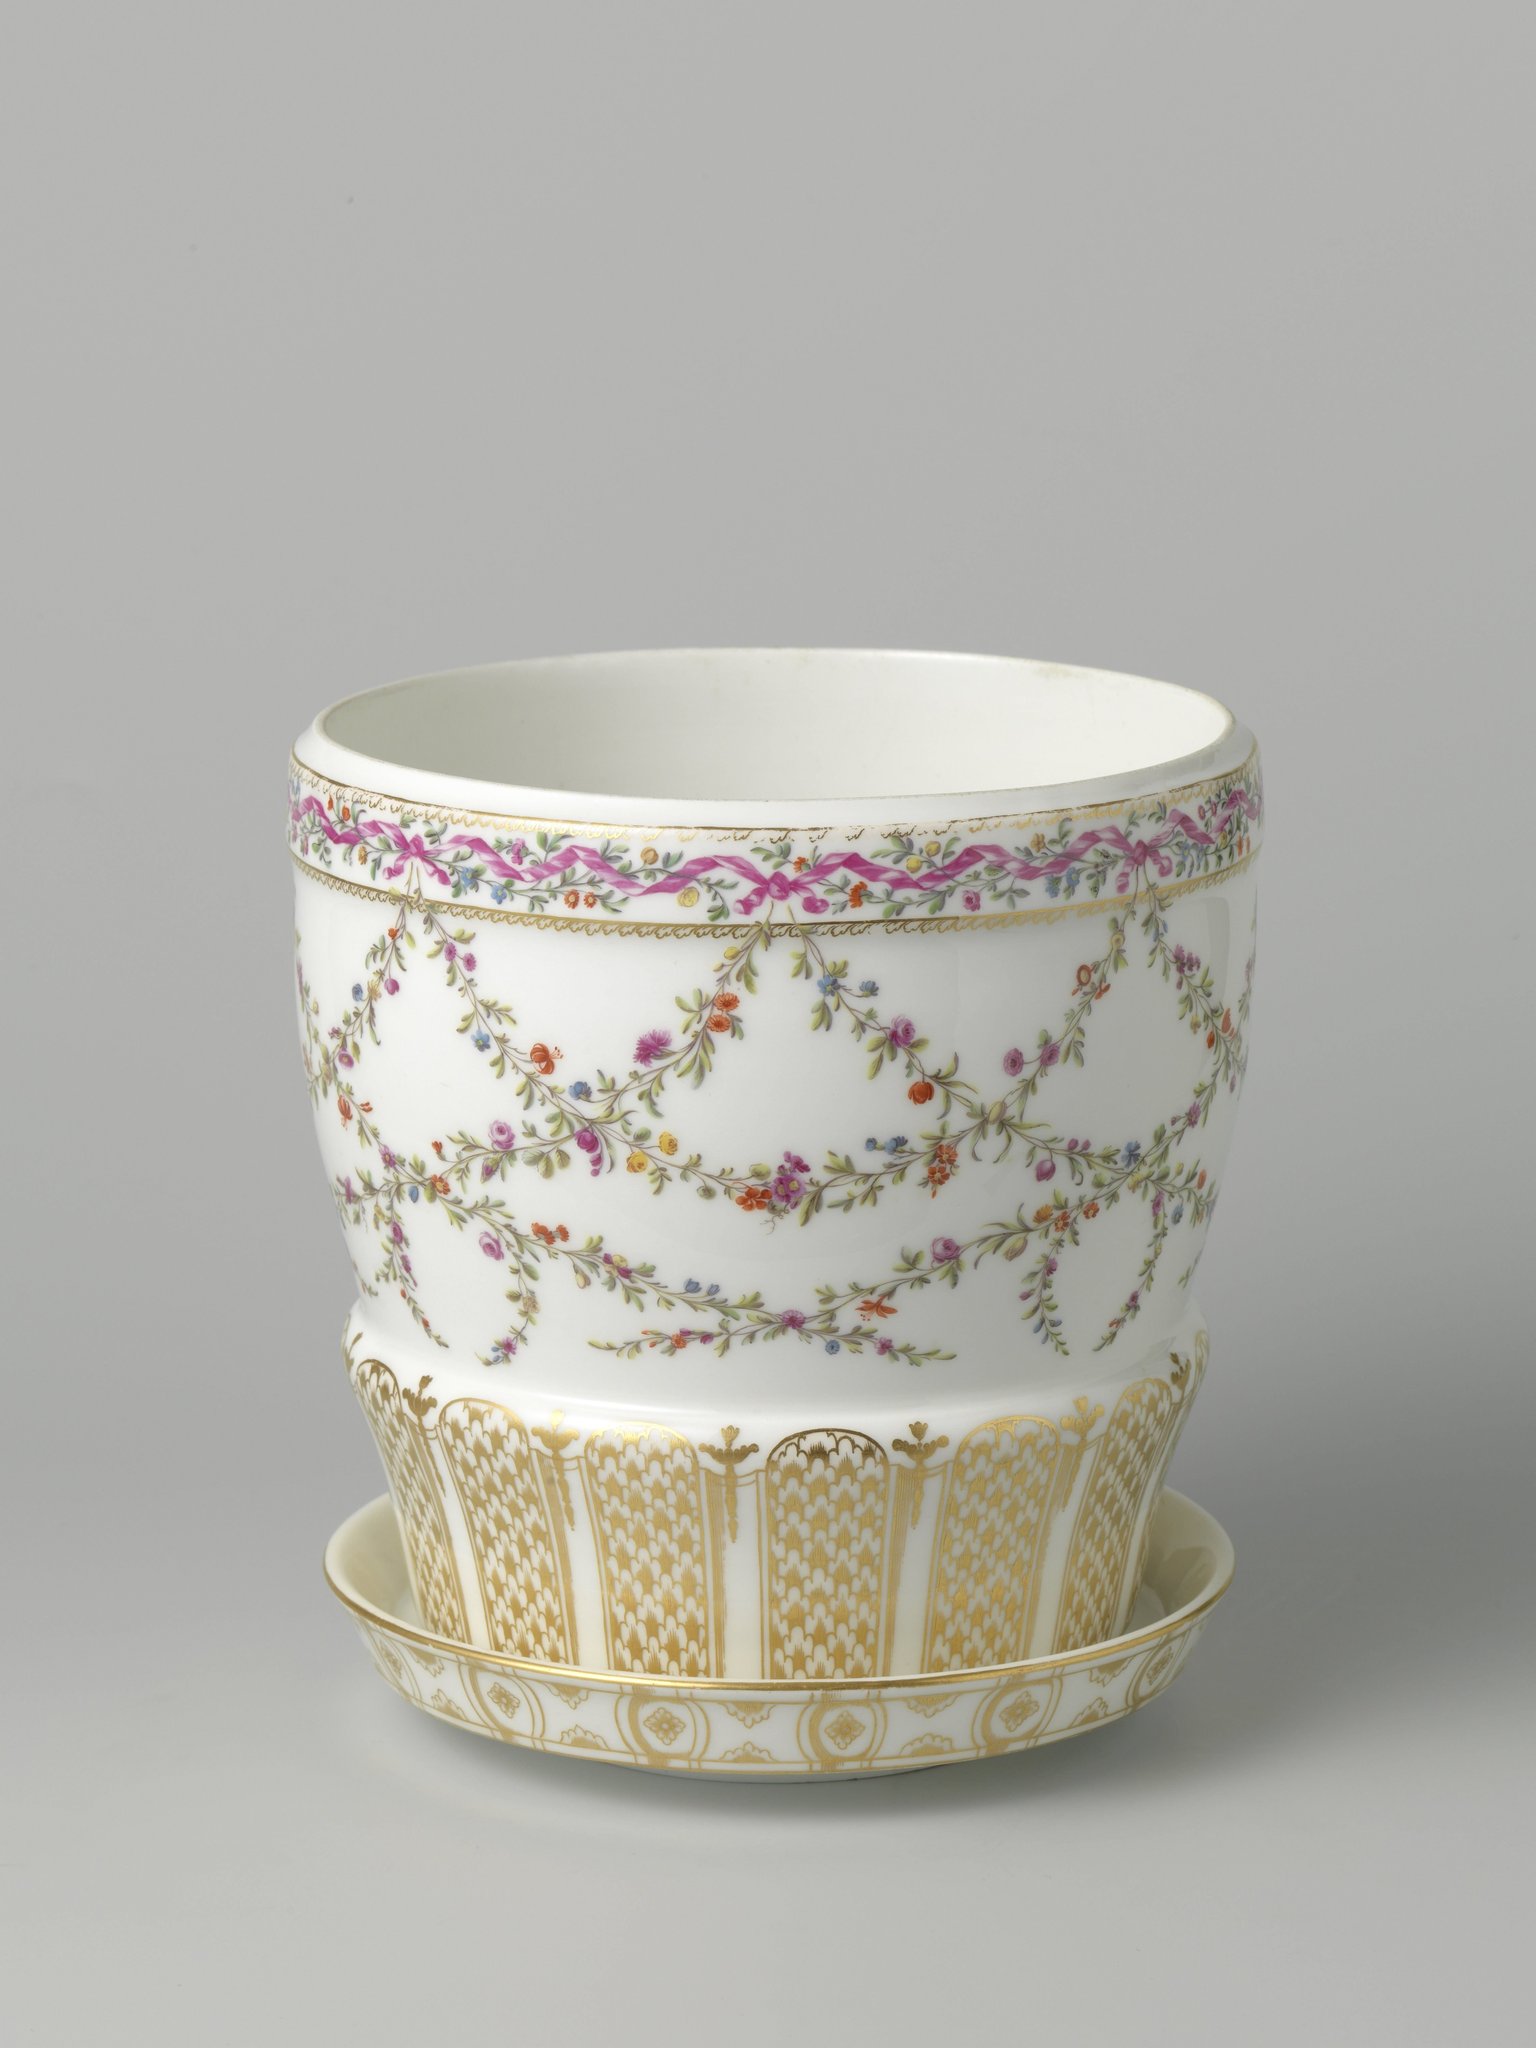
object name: platter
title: Two wine coolers and stands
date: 1778-1782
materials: porcelain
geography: loosdrecht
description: Manufactuur Oud-Loosdrecht Loosdrecht, c. 1778–1782 hard-paste porcelain